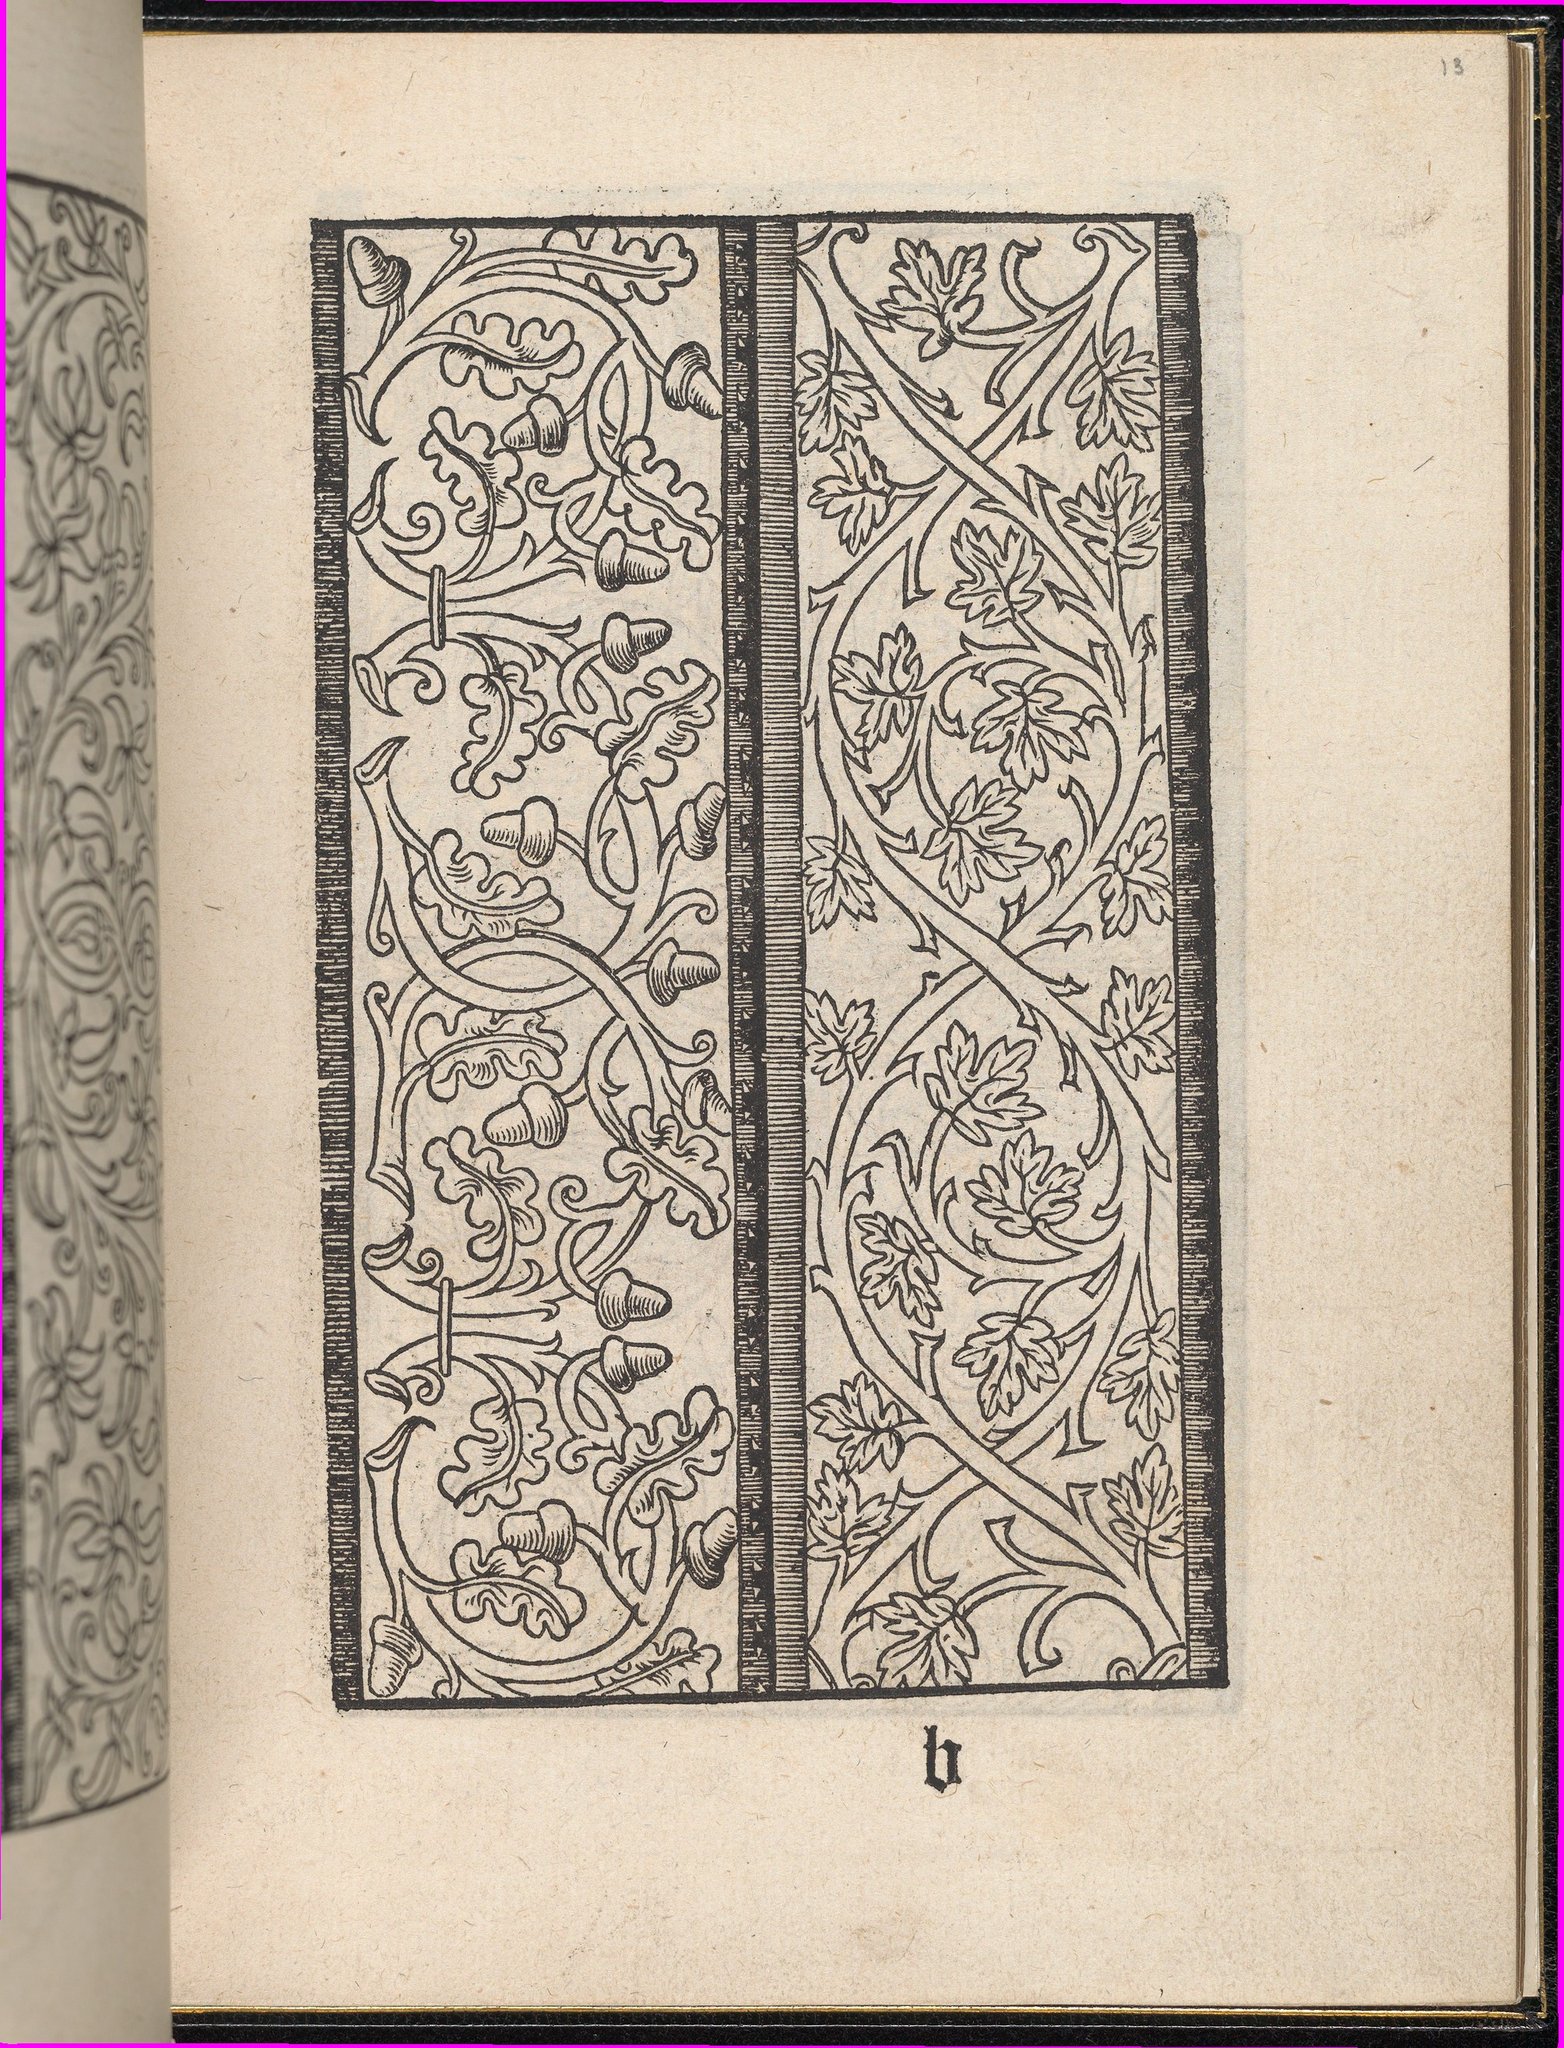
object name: book print ornament architecture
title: Page from Ein new kunstlich Modelbuch...(Page 13r)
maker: peter quentel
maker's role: publisher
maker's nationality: german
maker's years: 1500-1550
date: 1544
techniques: woodcut